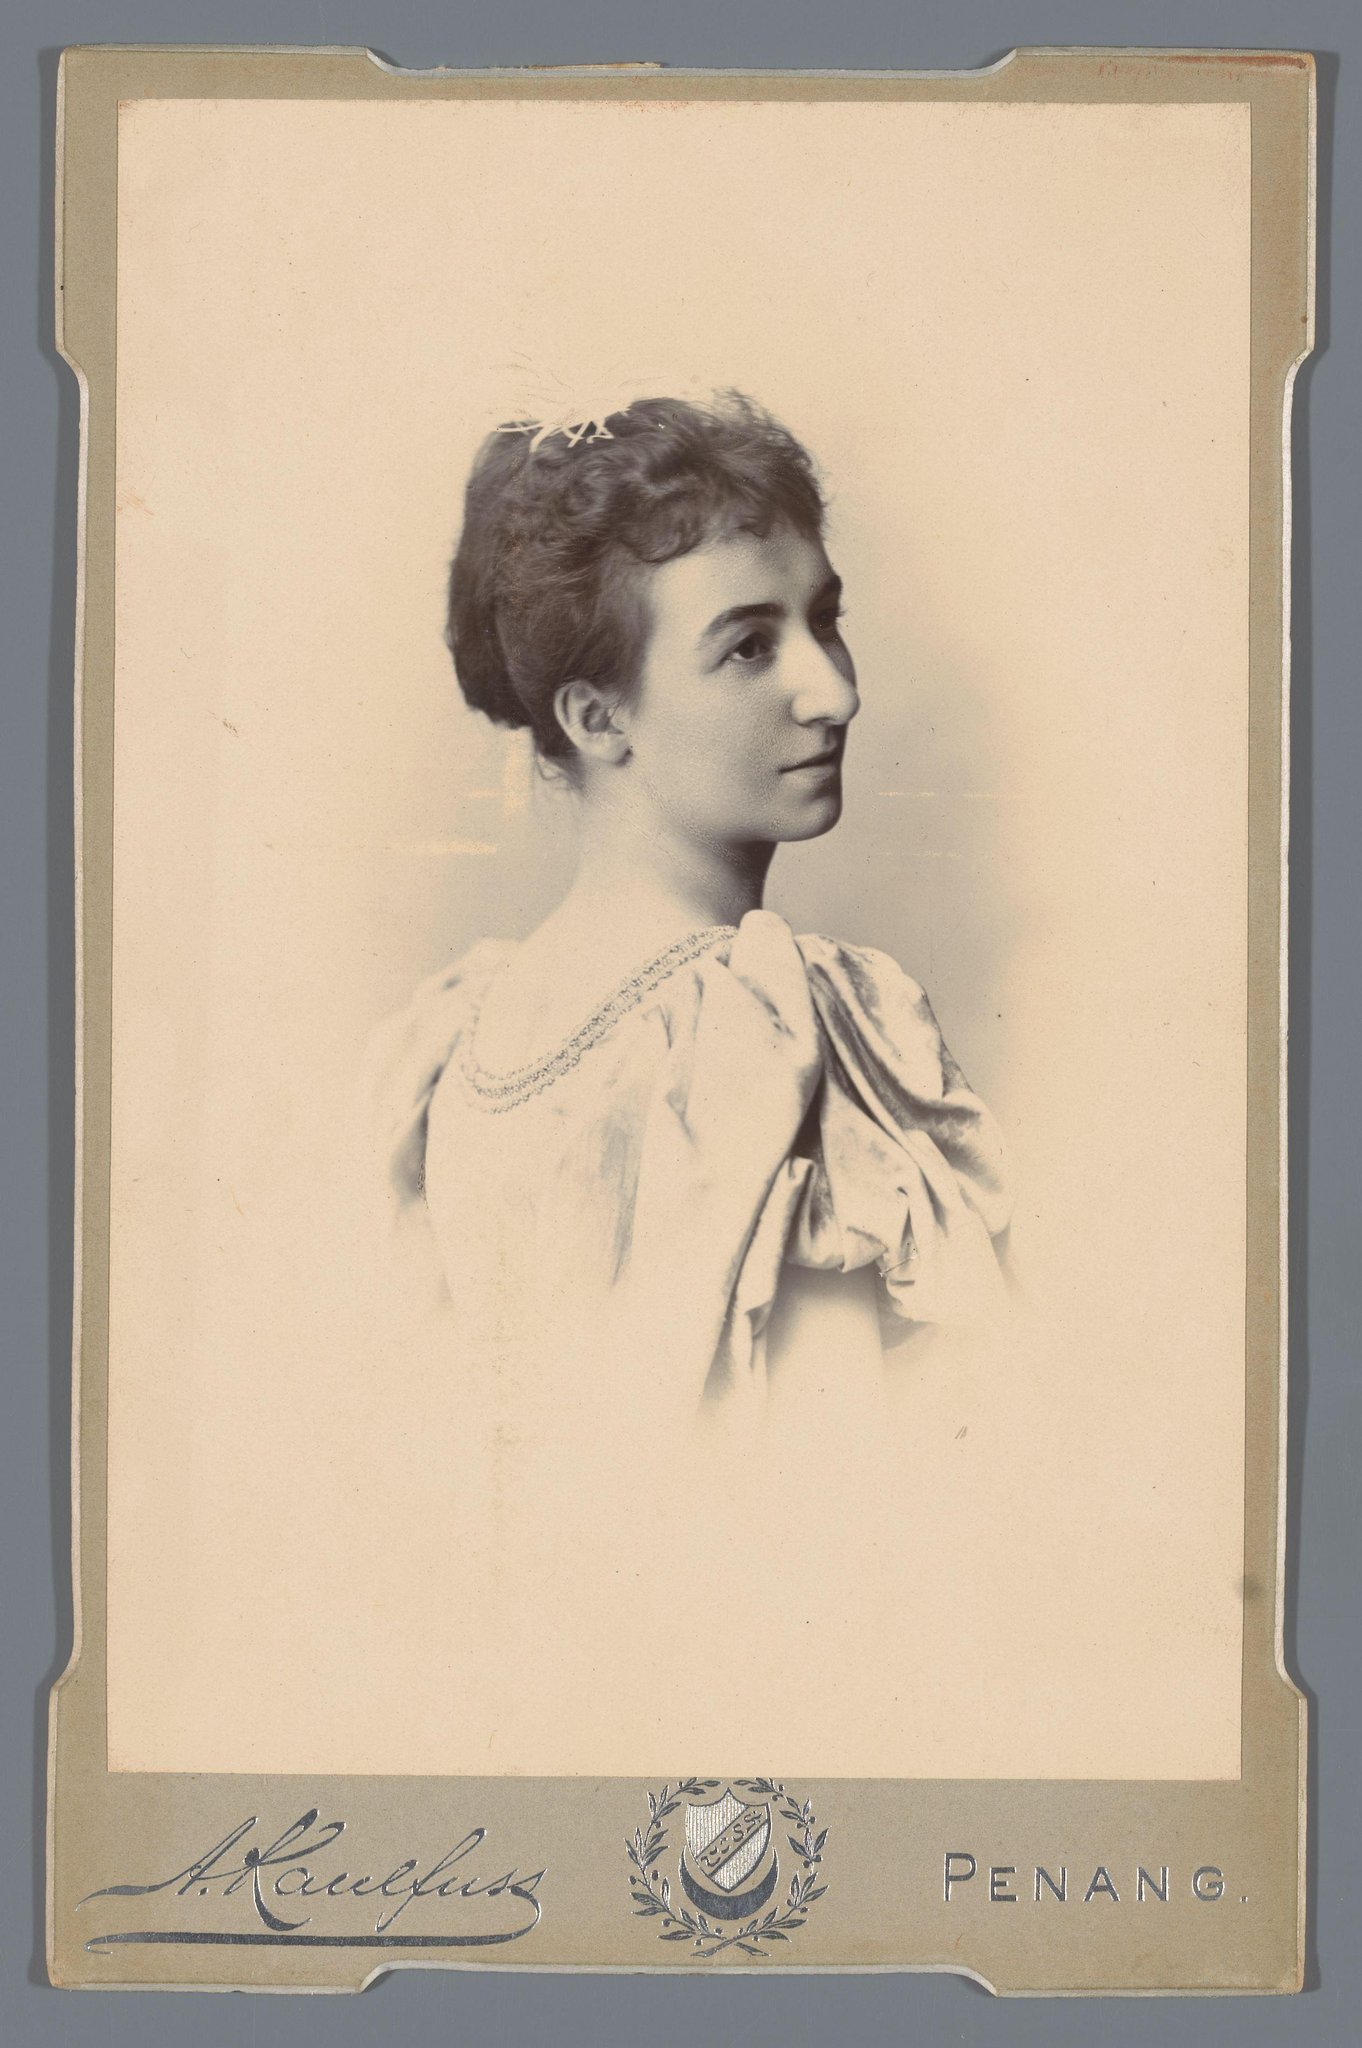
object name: cabinet photograph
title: Portret van een vrouw, vermoedelijk M. Marmelstein-Thornburn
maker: a. kaulfuss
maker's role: fotograaf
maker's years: 1861-1909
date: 1880-1885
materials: cardboard, photographic support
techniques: collodion silver print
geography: penang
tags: historical persons - bb - woman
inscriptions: annotation: ‘Ma 1897?’, inscription: ‘A. Kaulfuss/ Penang/ by special appointment/ photographer/ to/ H. H. The Sultan of Quedah./ Negatives kept./ Enlargements up to any size.’